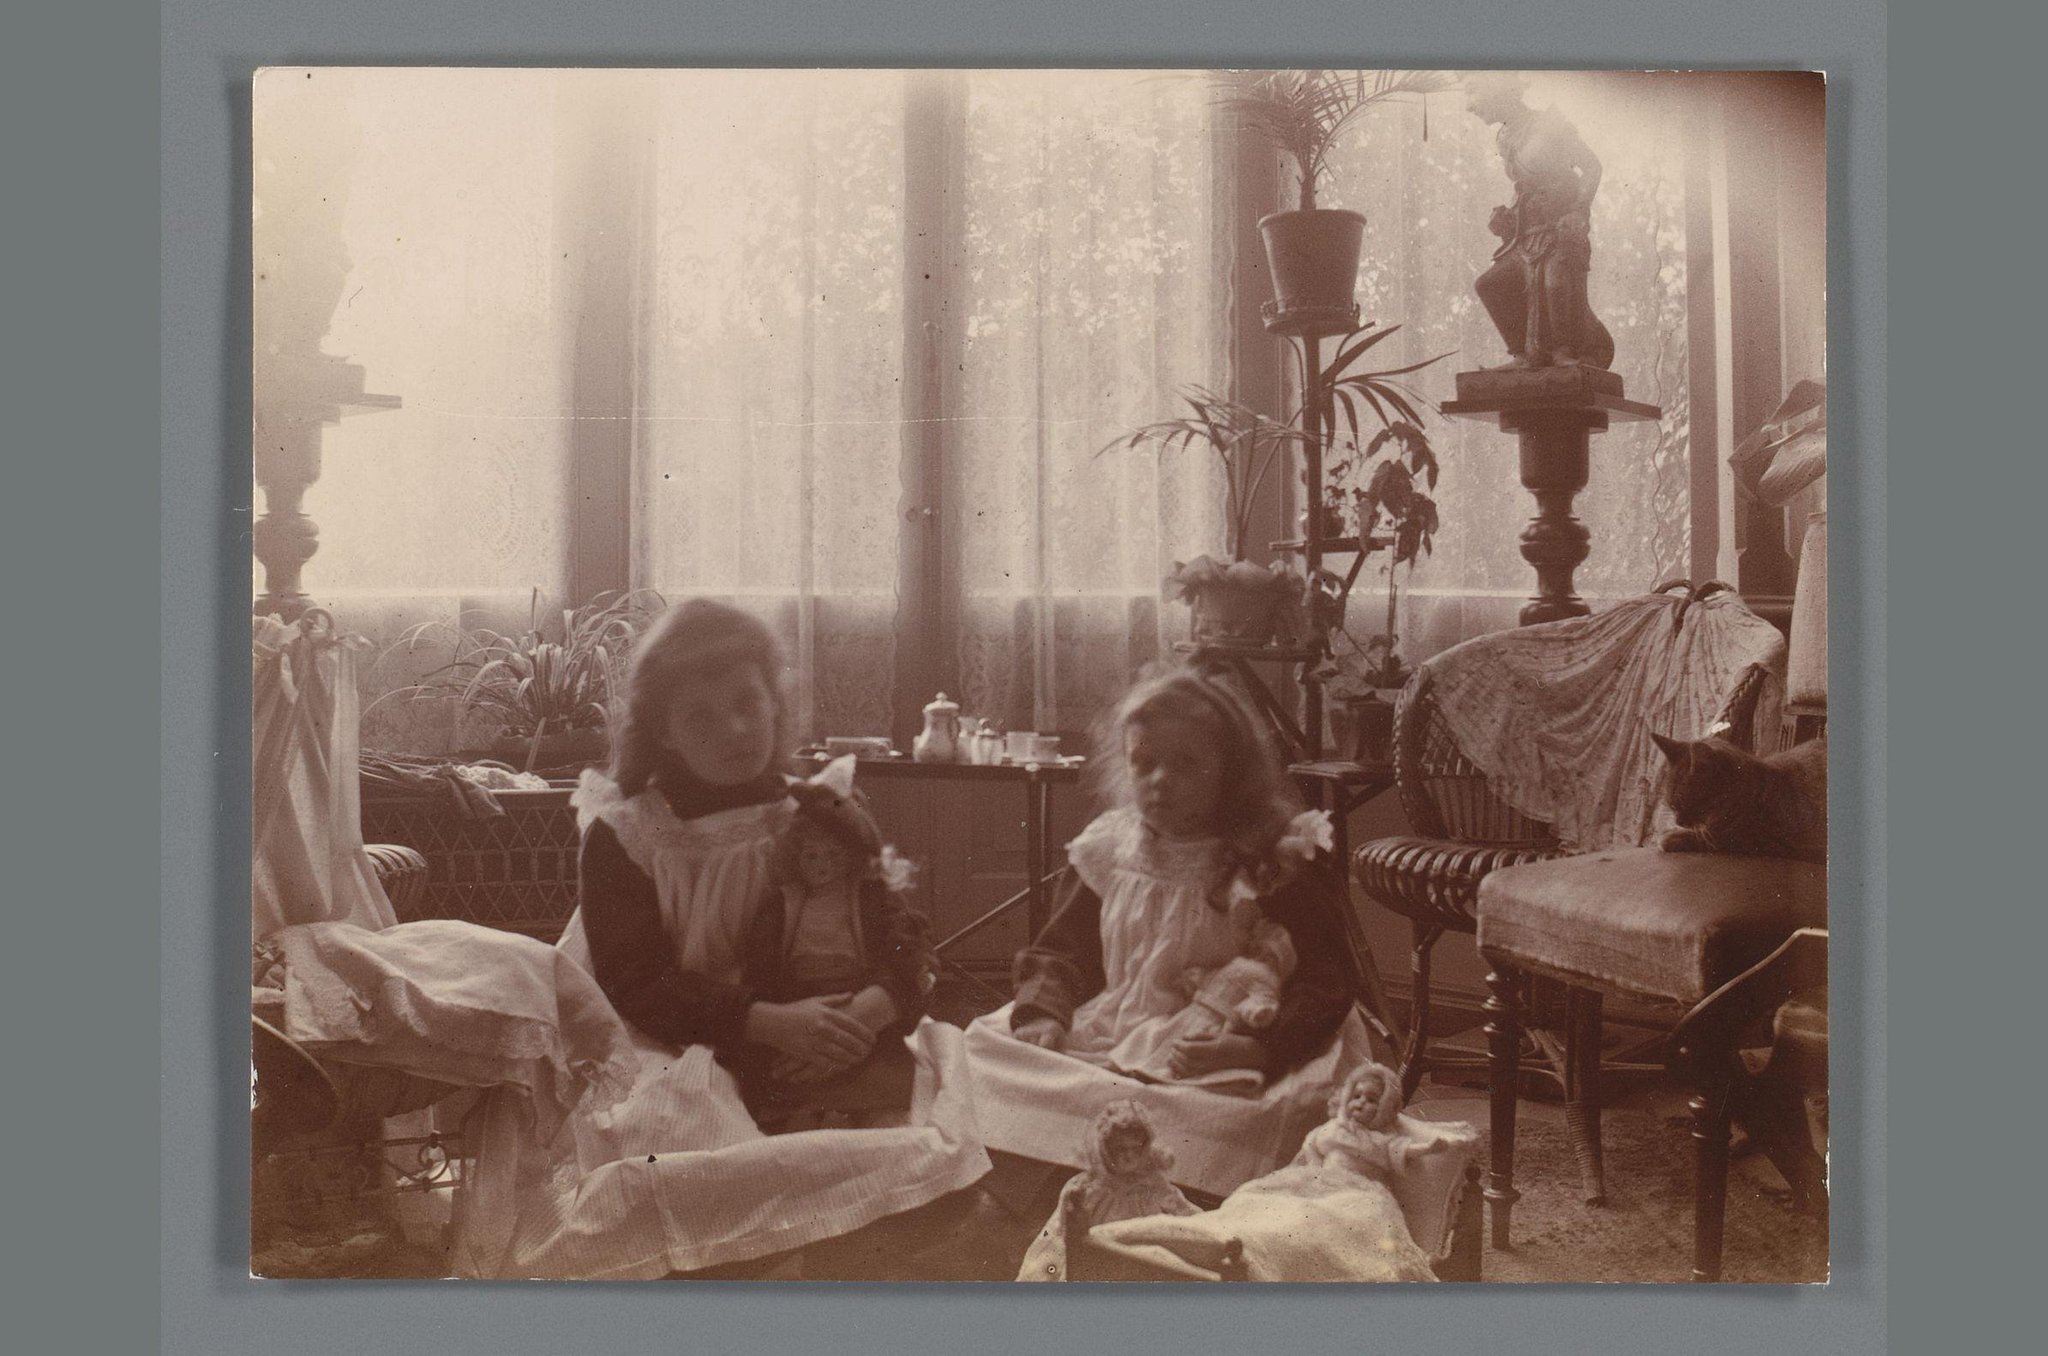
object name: photograph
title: Johanna (Hans) de Jong en Johanna (Nan) Vreede spelend met poppen in het huis van Piet en Hendrina (Dina) de Jong in Arnhem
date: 1900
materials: paper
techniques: gelatin silver print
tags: leiden, johanna petronella lambertina stokhuyzen-de jong (hans), johanna elisabeth borgerhoff mulder-vreede (nan), historical persons, (playing with) dolls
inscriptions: inscription: ‘Nan + Hansje’